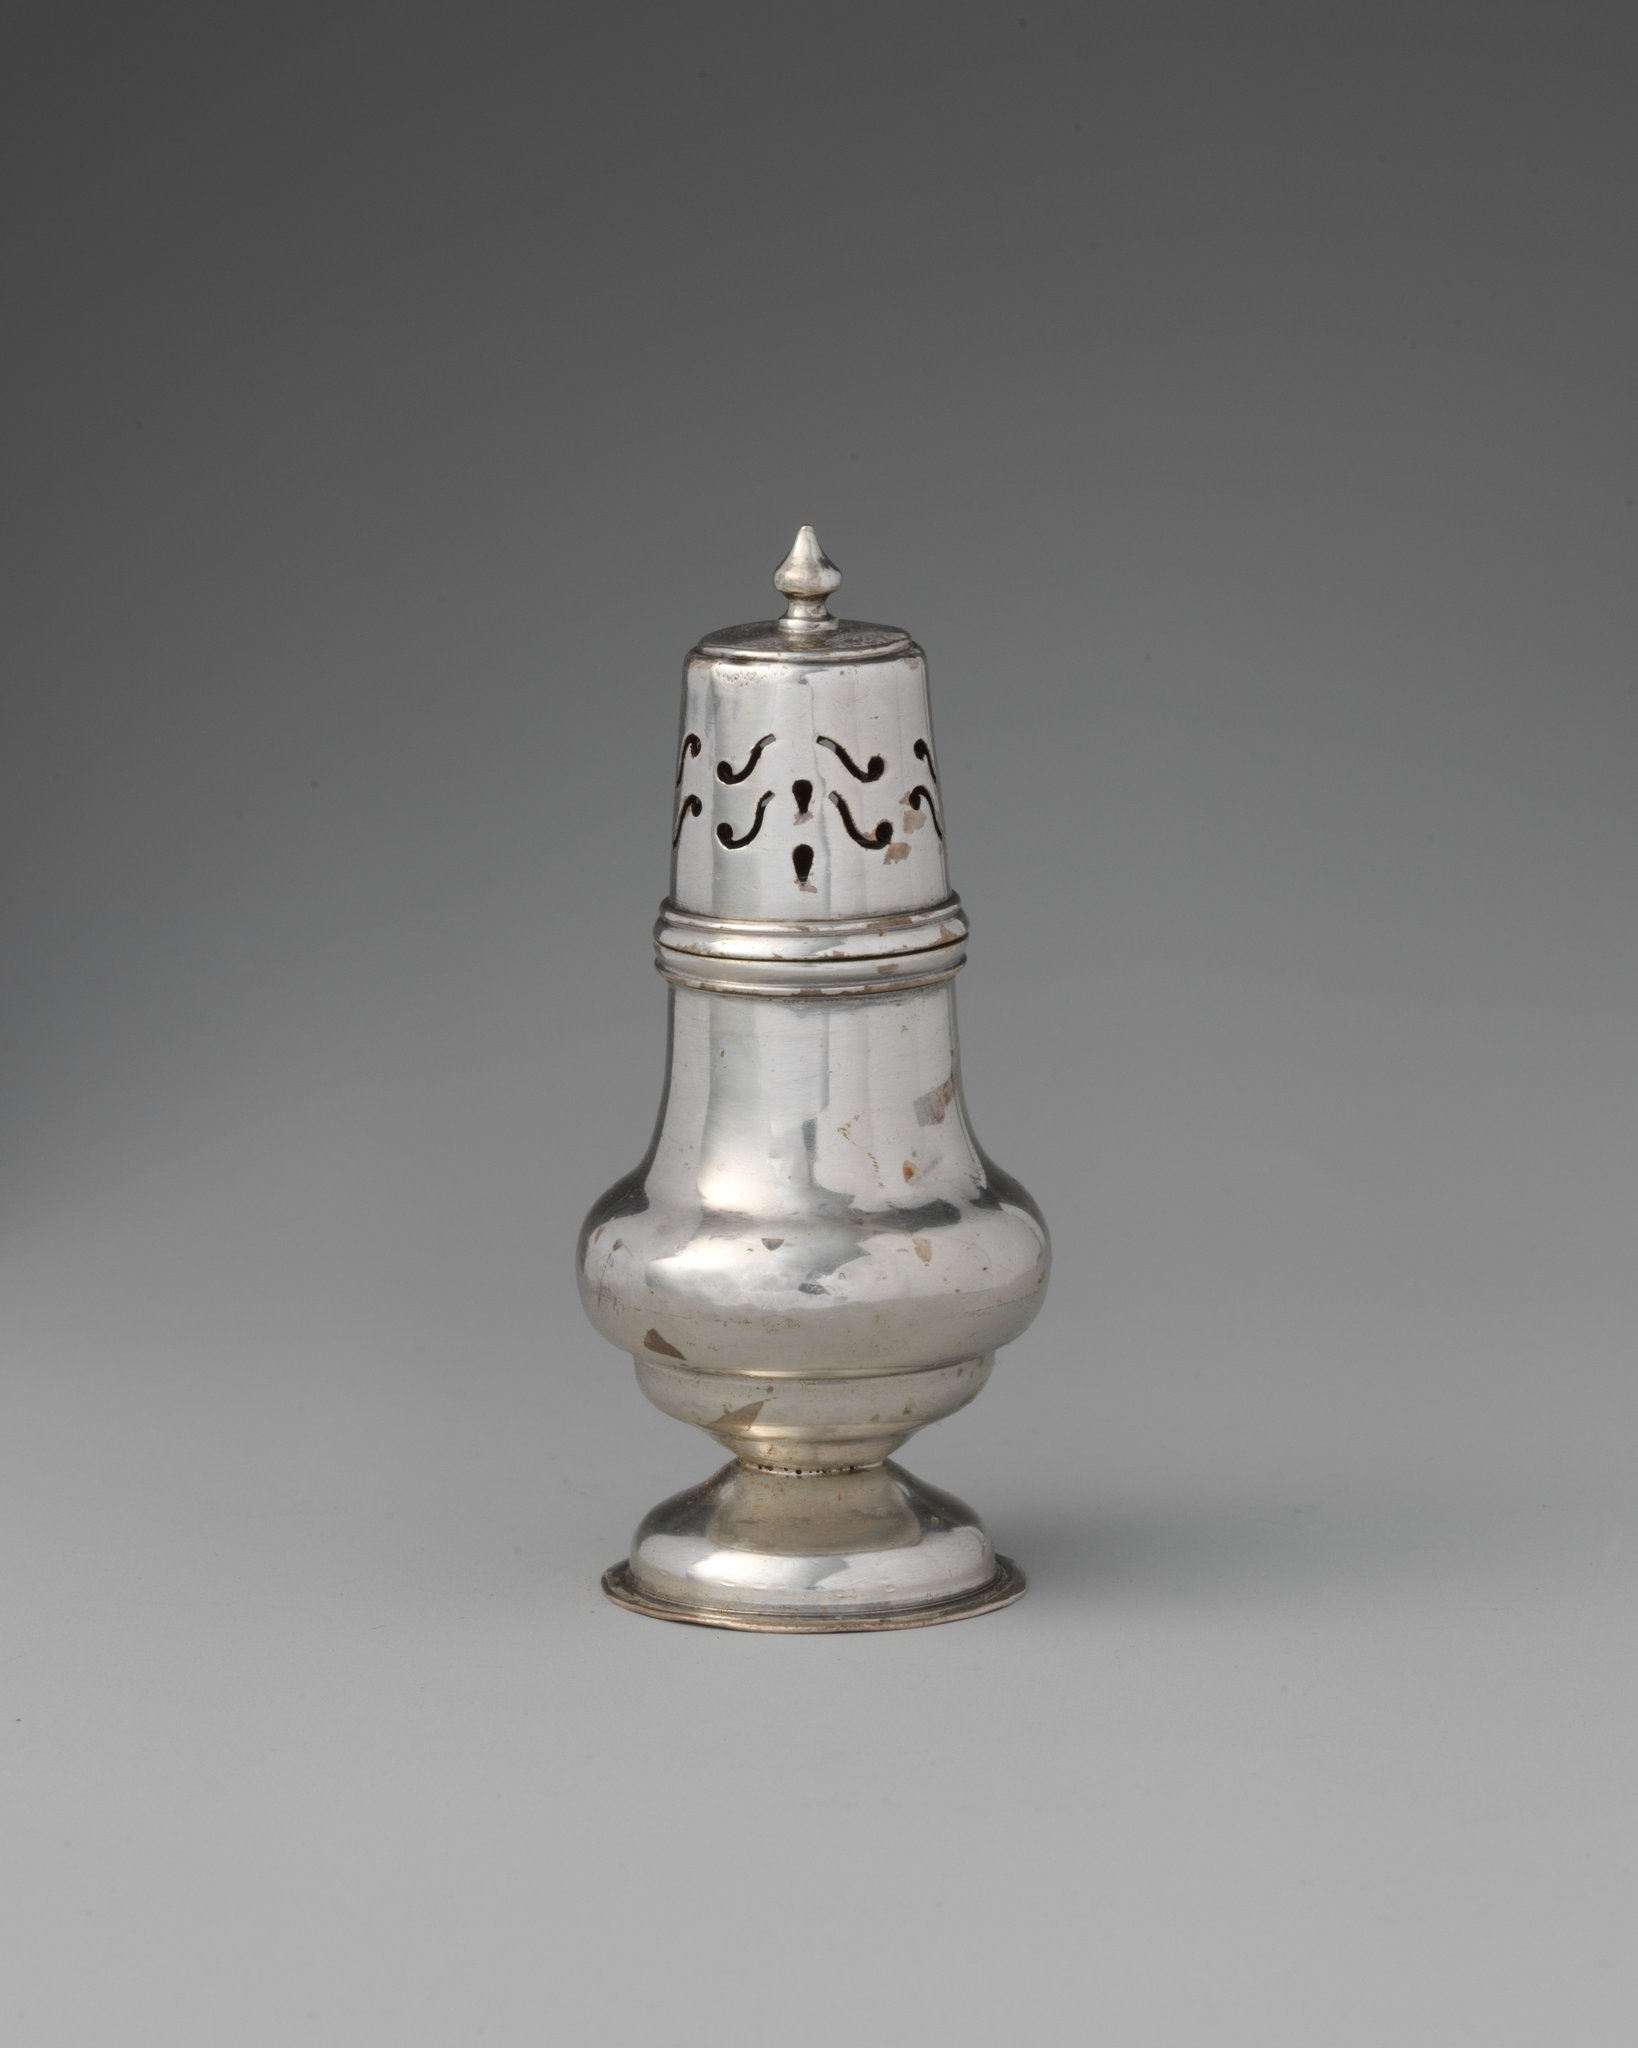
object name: cruet with cover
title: Miniature cruet with cover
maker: s. a.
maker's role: maker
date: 1738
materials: silver